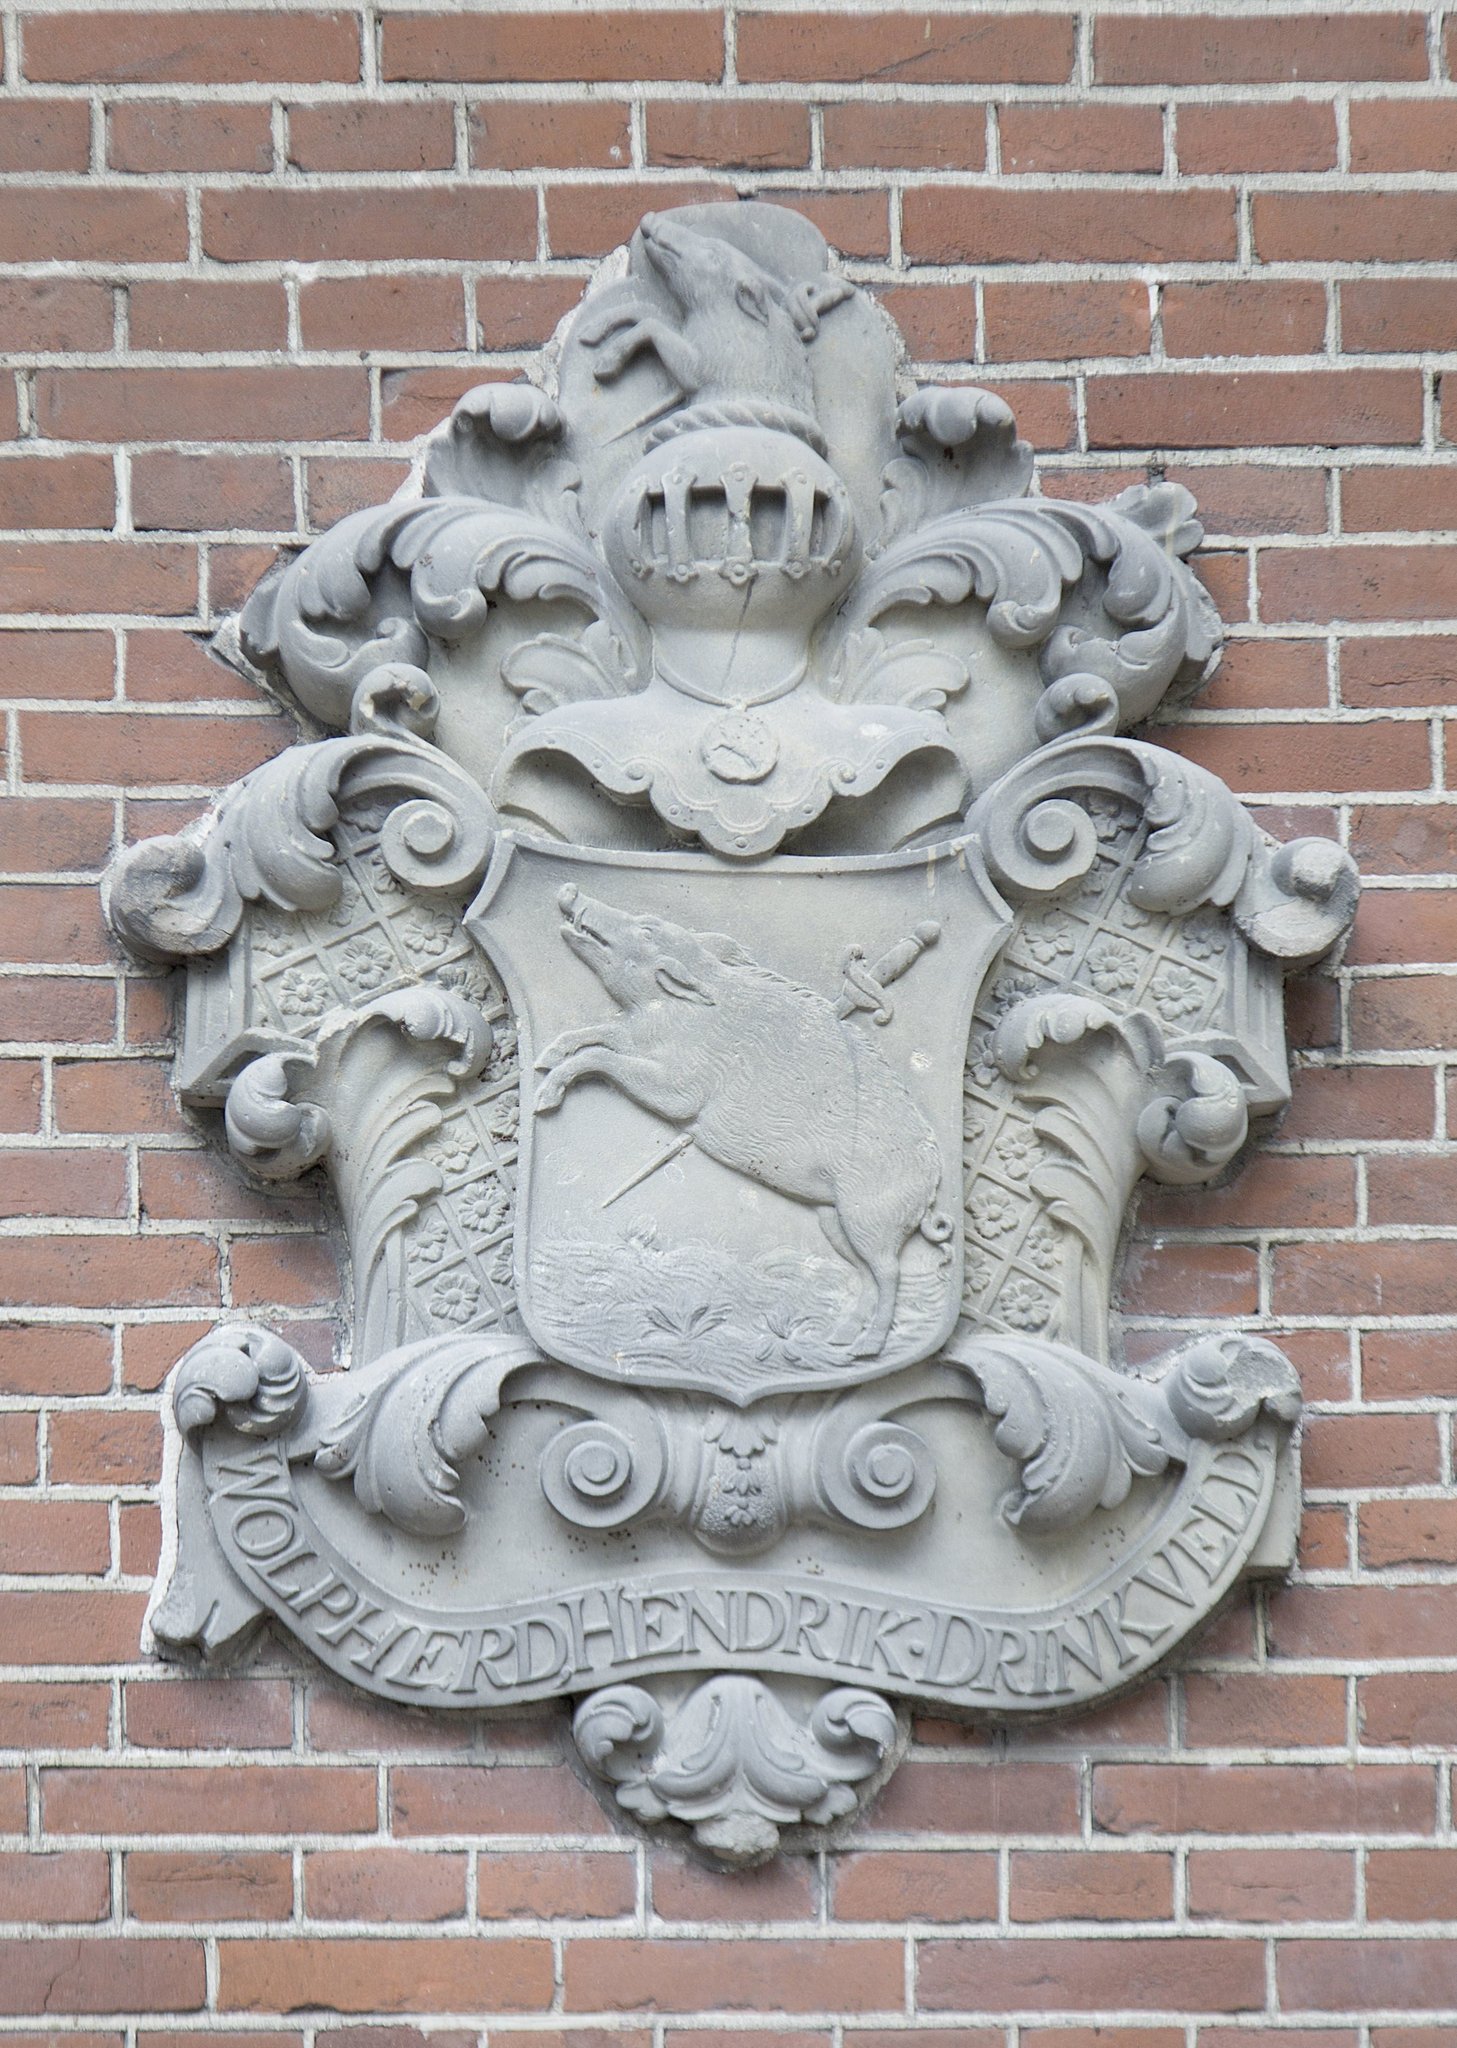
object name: gable stone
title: Gevelsteen met het wapen van Wolpherd Hendrik Drinkveld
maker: Anonymous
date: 1735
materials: stone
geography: netherlands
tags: wolpherd hendrik drinkveld, leprozenhuis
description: Gevelsteen met het wapen van regent Wolpherd Hendrik Drinkveld. Afkomstig van het Leprozenhuis te Amsterdam.